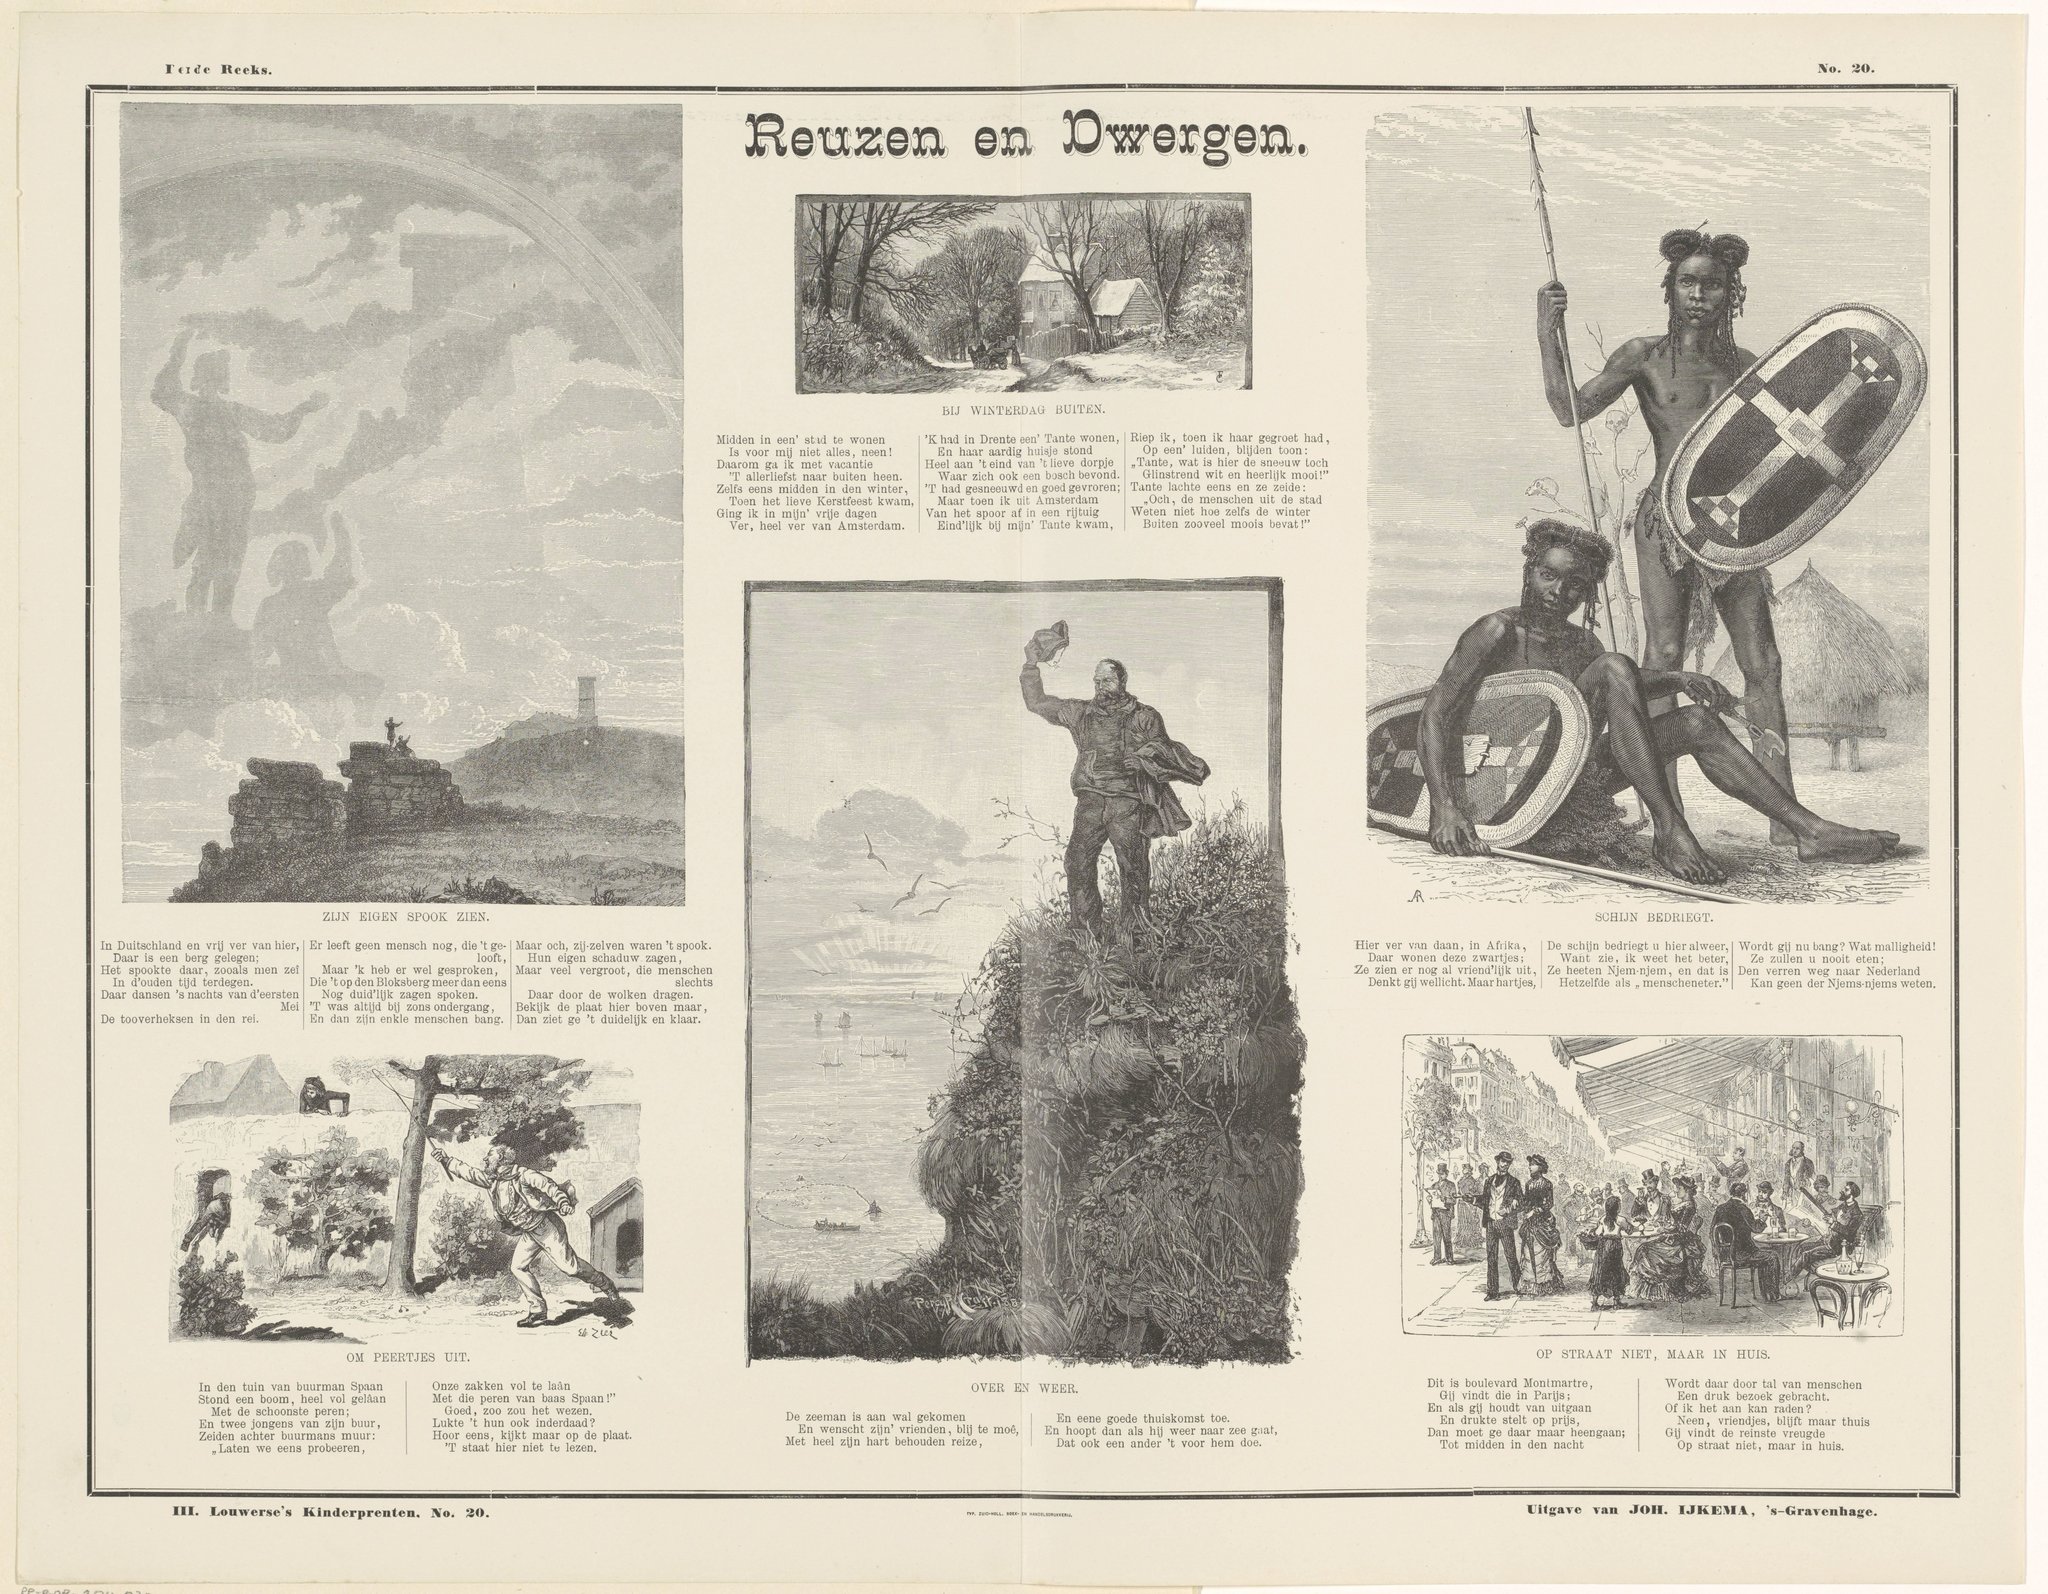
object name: print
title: Reuzen en dwergen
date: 1892-1905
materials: paper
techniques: letterpress printing, printing block, engraving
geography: the hague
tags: africans, winter landscape; landscape symbolizing winter (the four seasons of the year), seaman: sailor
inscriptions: collector's mark: Lugt 2760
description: Blad met 6 voorstellingen van verschillende aard, waaronder voorstellingen van een winterlandschap, Afrikanen en een zeeman die zijn vrienden uitzwaait vanaf de wal. Tussen de afbeeldingen versjes in boekdruk. Genummerd rechtsboven en linksonder: No. 20.